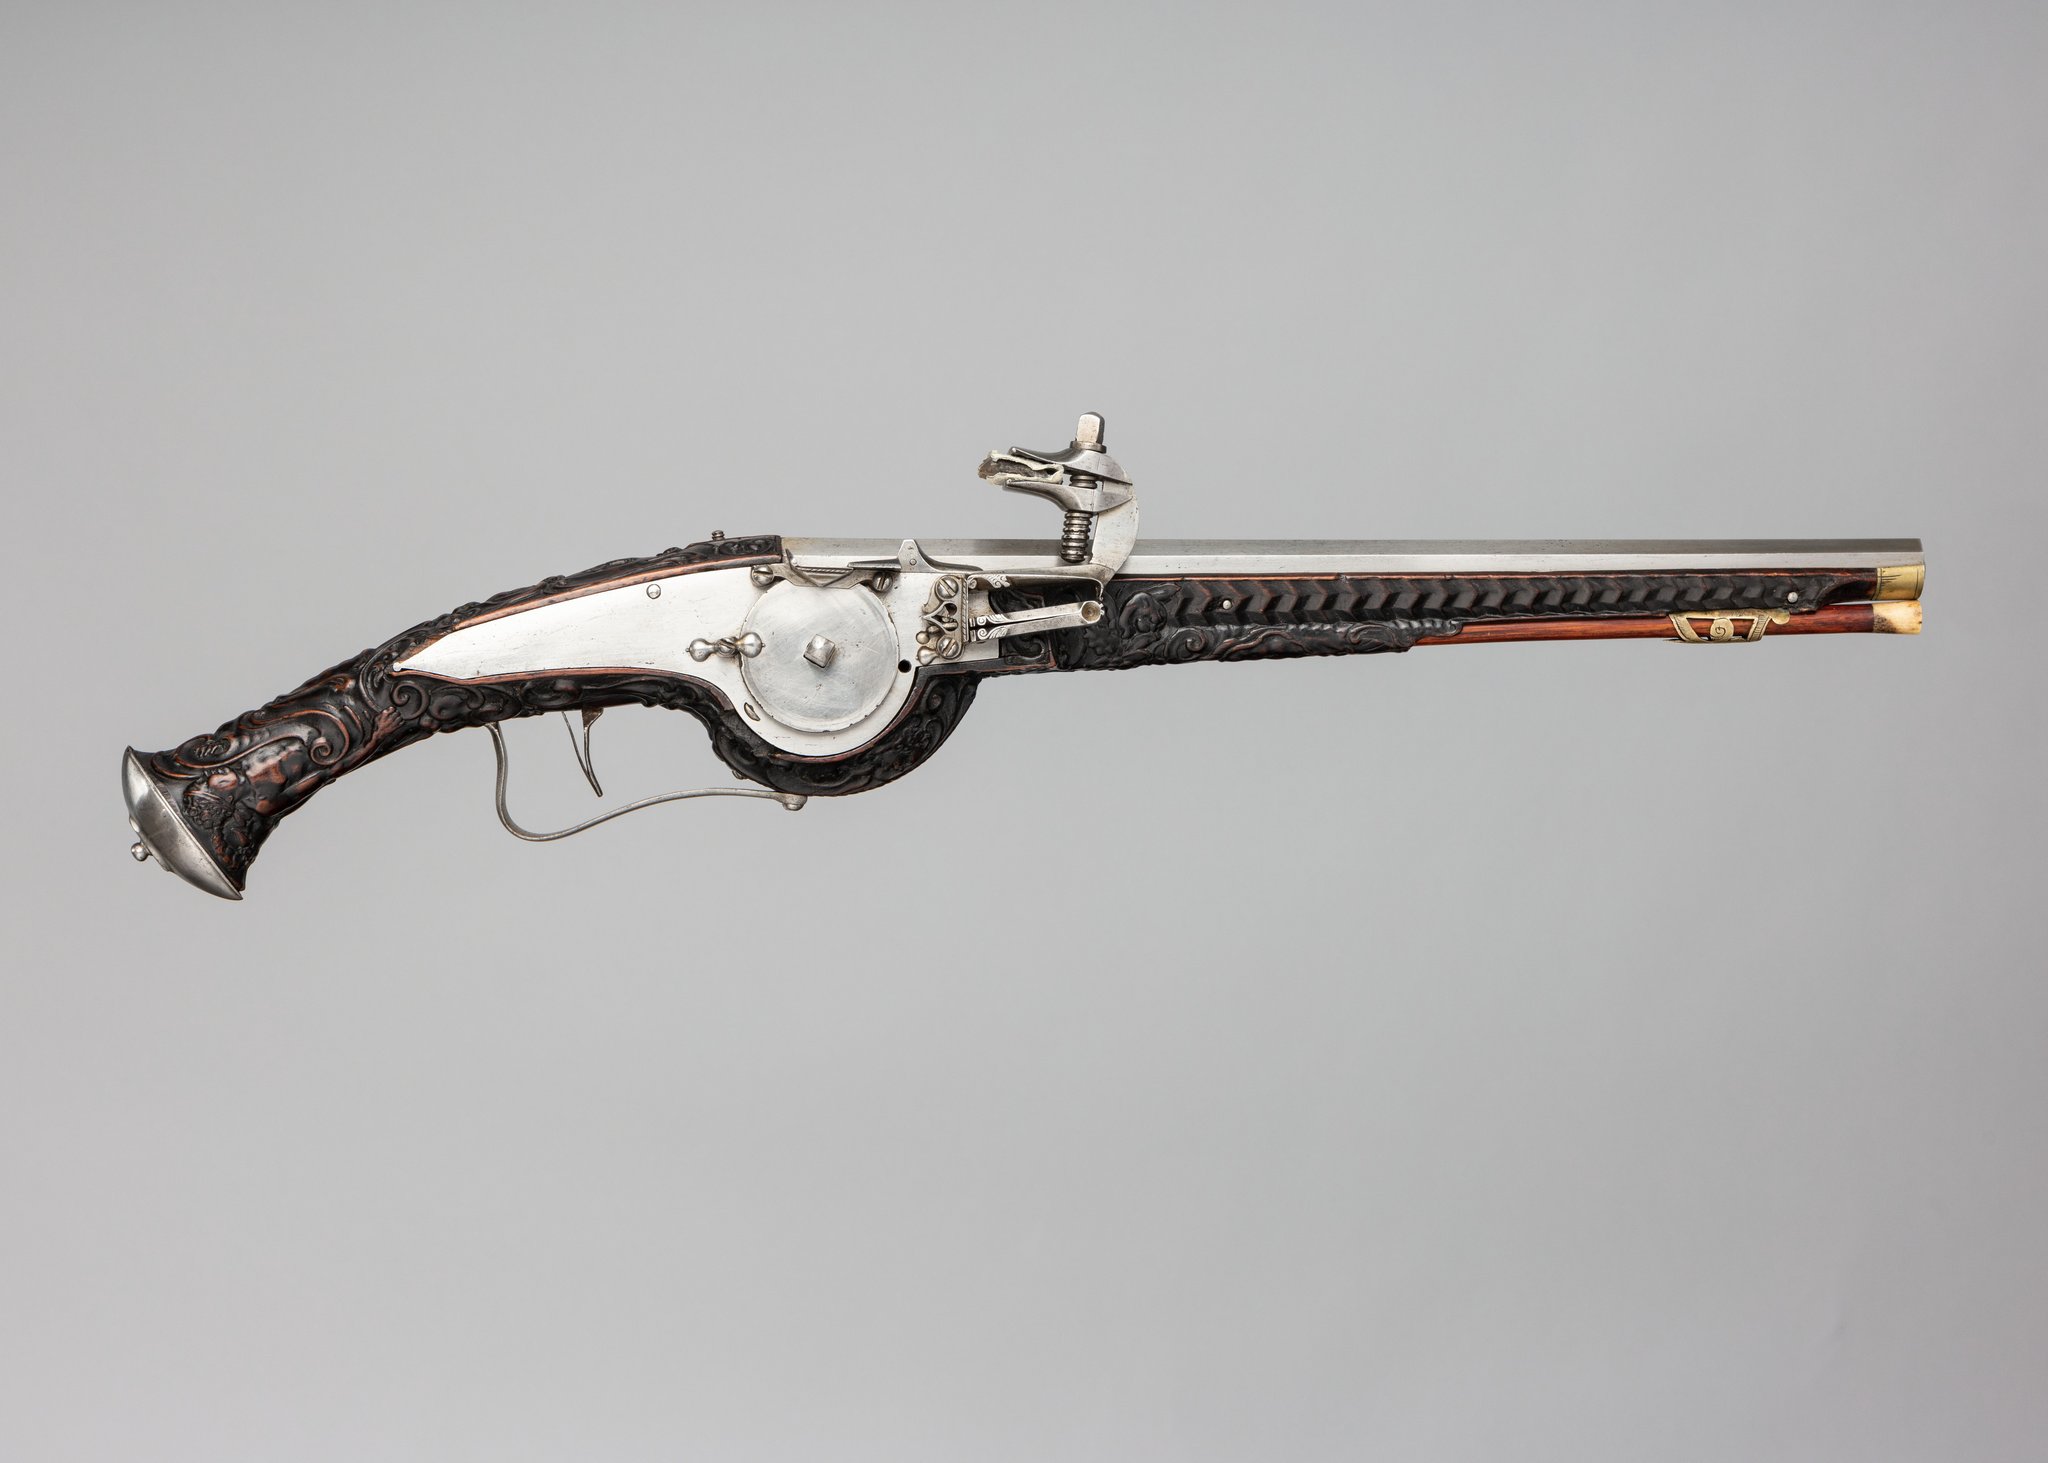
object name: wheellock pistol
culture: swiss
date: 1650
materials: brass, steel, wood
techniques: stain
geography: switzerland